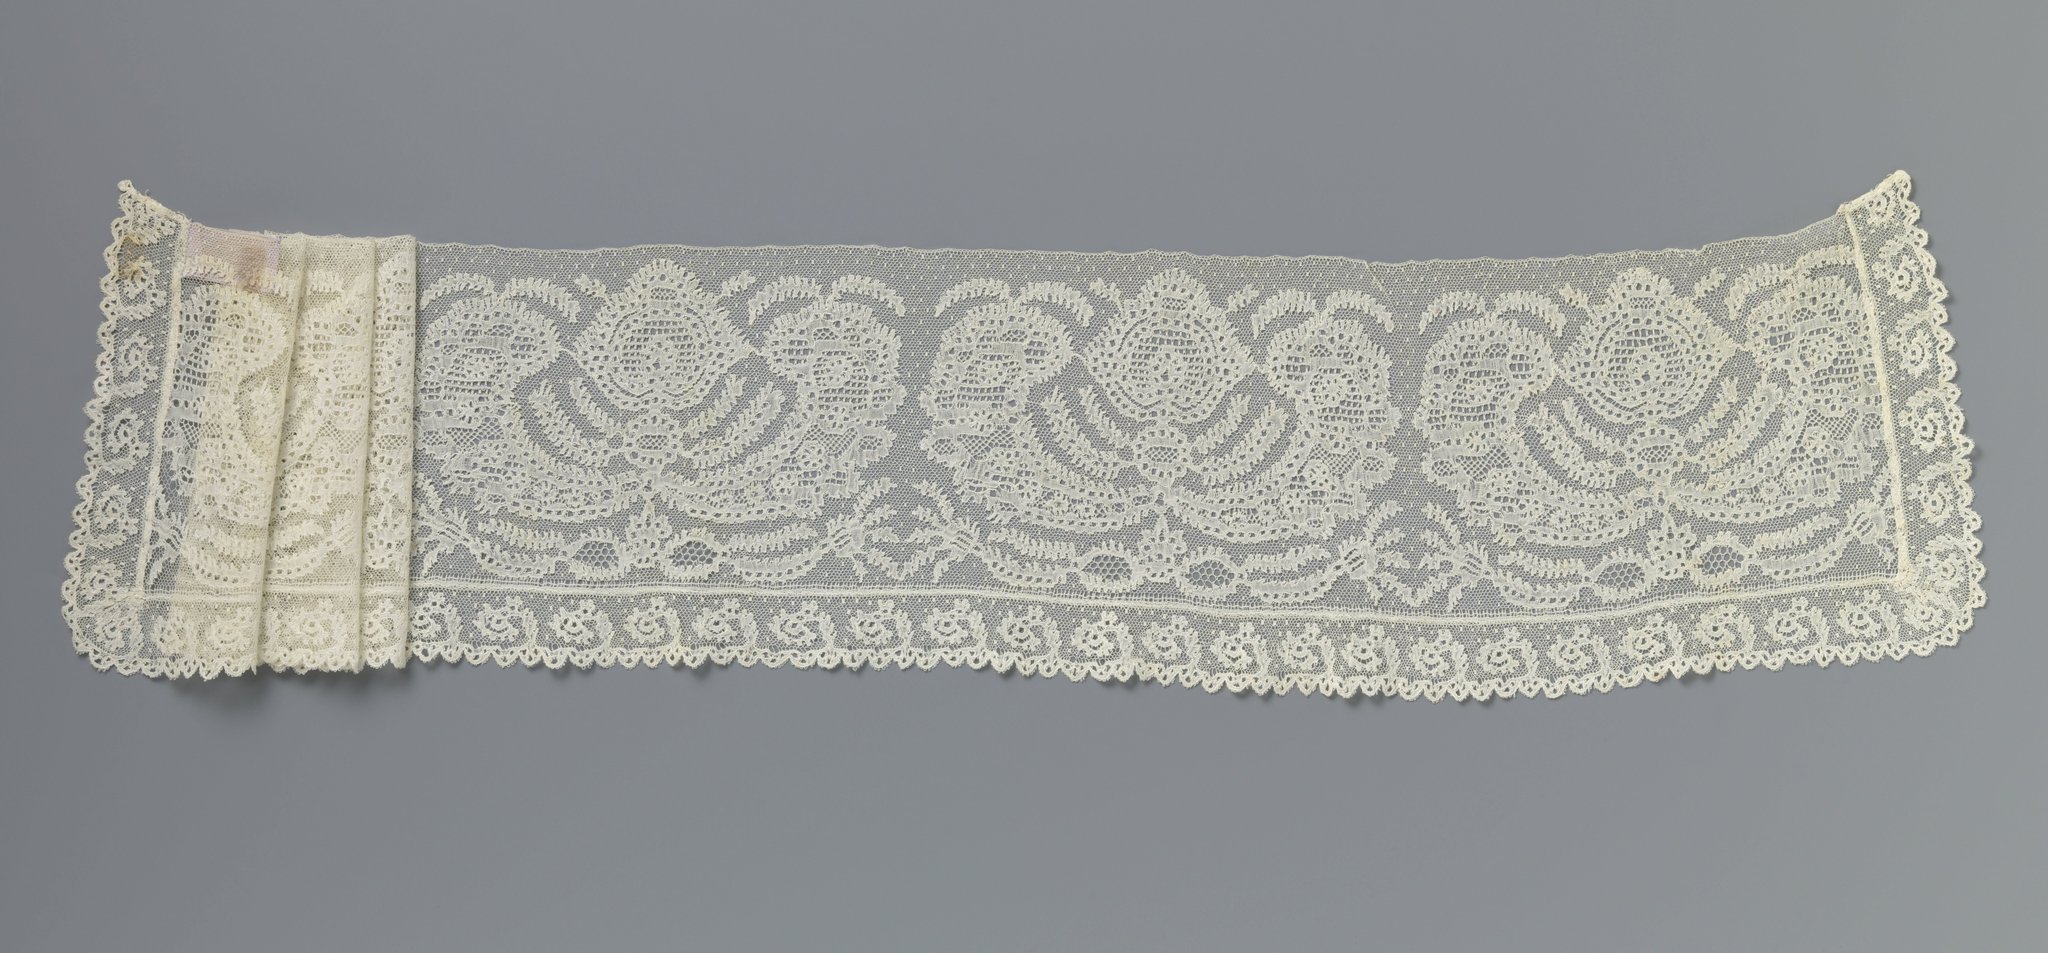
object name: strip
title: Strook kloskant met gestileerde ronde bloem tussen twee dikke c-voluten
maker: Anonymous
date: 1850-1899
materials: linen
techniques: lace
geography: beveren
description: Strook naturelkleurige kloskant: Beverse kant. De strook is aan één lange en twee korte zijden afgewerkt met een smallere strook Rijselse kant. Het zich herhalende en symmetrische patroon van de brede strook bestaat uit een gestileerde ronde bloem tussen twee dikke c-voluten, zoals bij een kandelaber met drie armen. Het zich herhalende patroon van de smalle strook bestaat uit een eenzijdig gebogen stengel met een waaiervormige bloem. De motieven zijn met elkaar verbonden door een fijne traliegrond, een tulegrond, die is bezaaid met vierkante moesjes. De motieven zijn gemaakt in linnenslag met veelal grote uitsparingen en dikkere en glimmende contourdraden. Er zijn verschillende siergronden toegepast, waaronder zogenoemde leerkens of 'laddertjes' gemaakt in vormslag, in de ronde bloem en in de voluten. De moesjes zijn ook gemaakt in vormslag. De bovenzijden van beide stroken zijn recht afgewerkt. De schulpjes langs de onderzijde van de smalle strook zijn afgewerkt met picots.